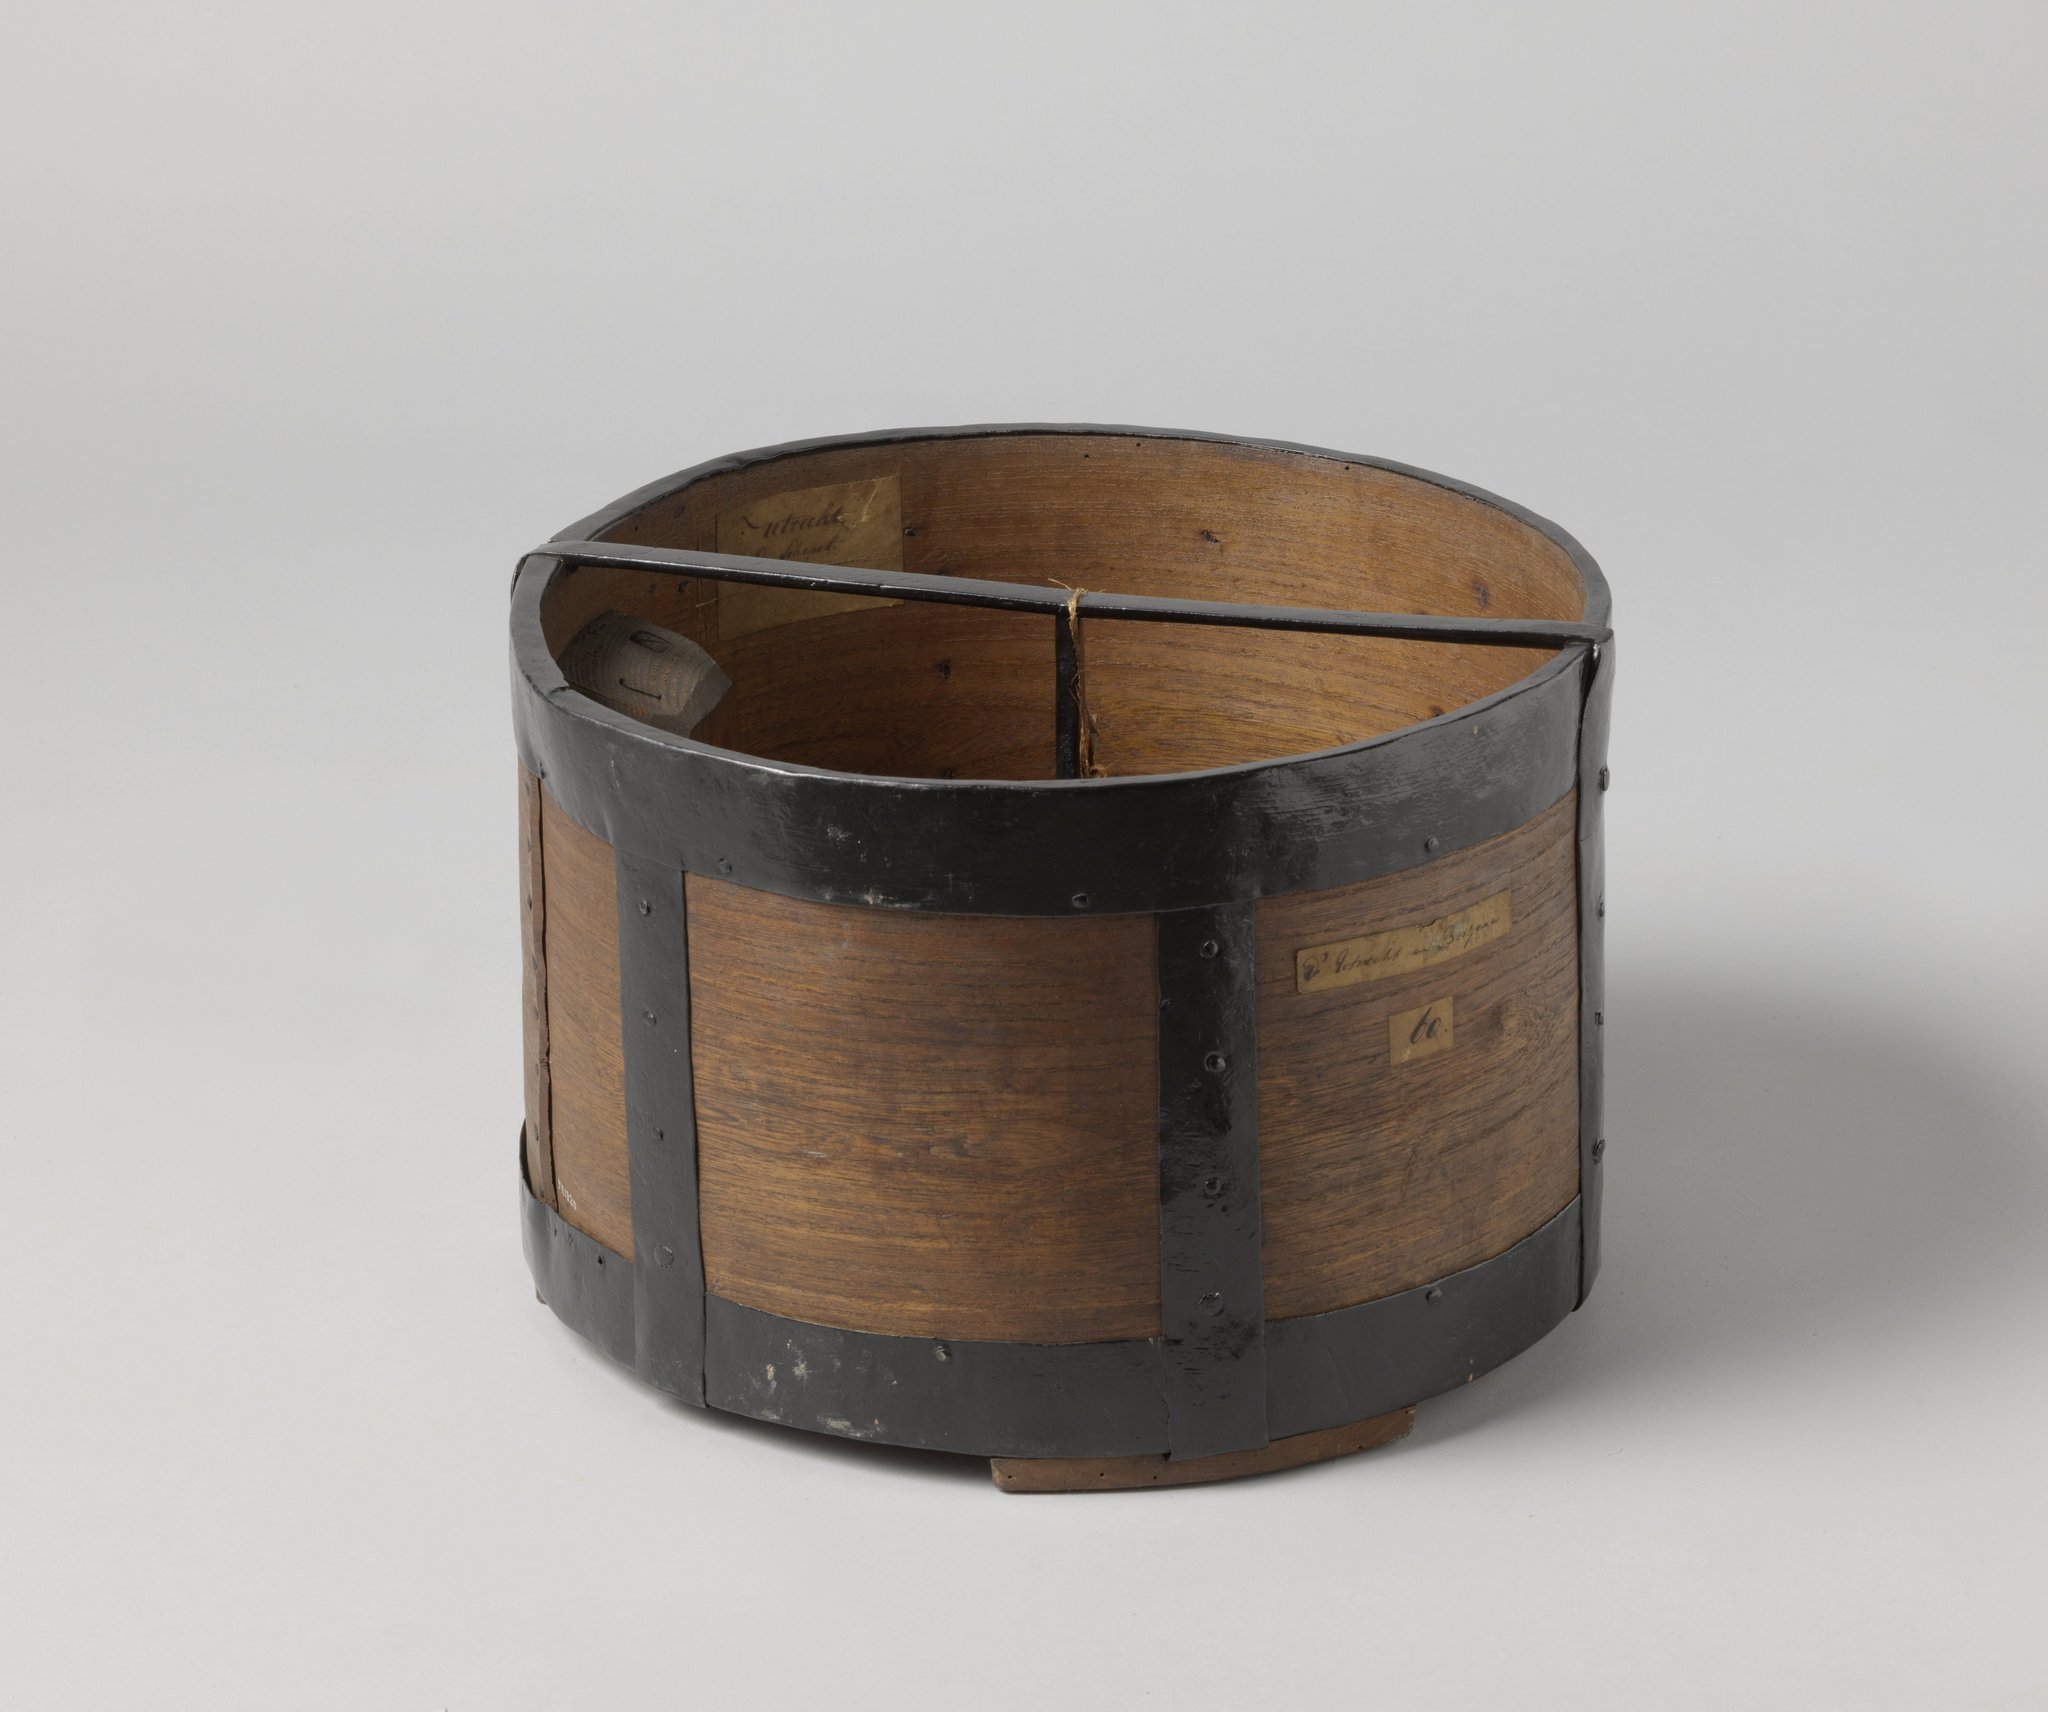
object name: inhoudsmaat droge waren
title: Een Boisseau uit Utrecht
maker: Anonymous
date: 1800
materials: wood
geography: utrecht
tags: utrecht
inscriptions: inscription: ‘Utrecht / Een Schepel’, : ‘J’, number: ‘60’, date: ‘1800’, title: ‘D'Utrecht un Boisseau / 60’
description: Spanen inhoudsmaat voor droge waren van 1 Boisseau met brug en stijl en blok aan binnenzijde, v.z.v. merk, label aan een lintje en etiketten.